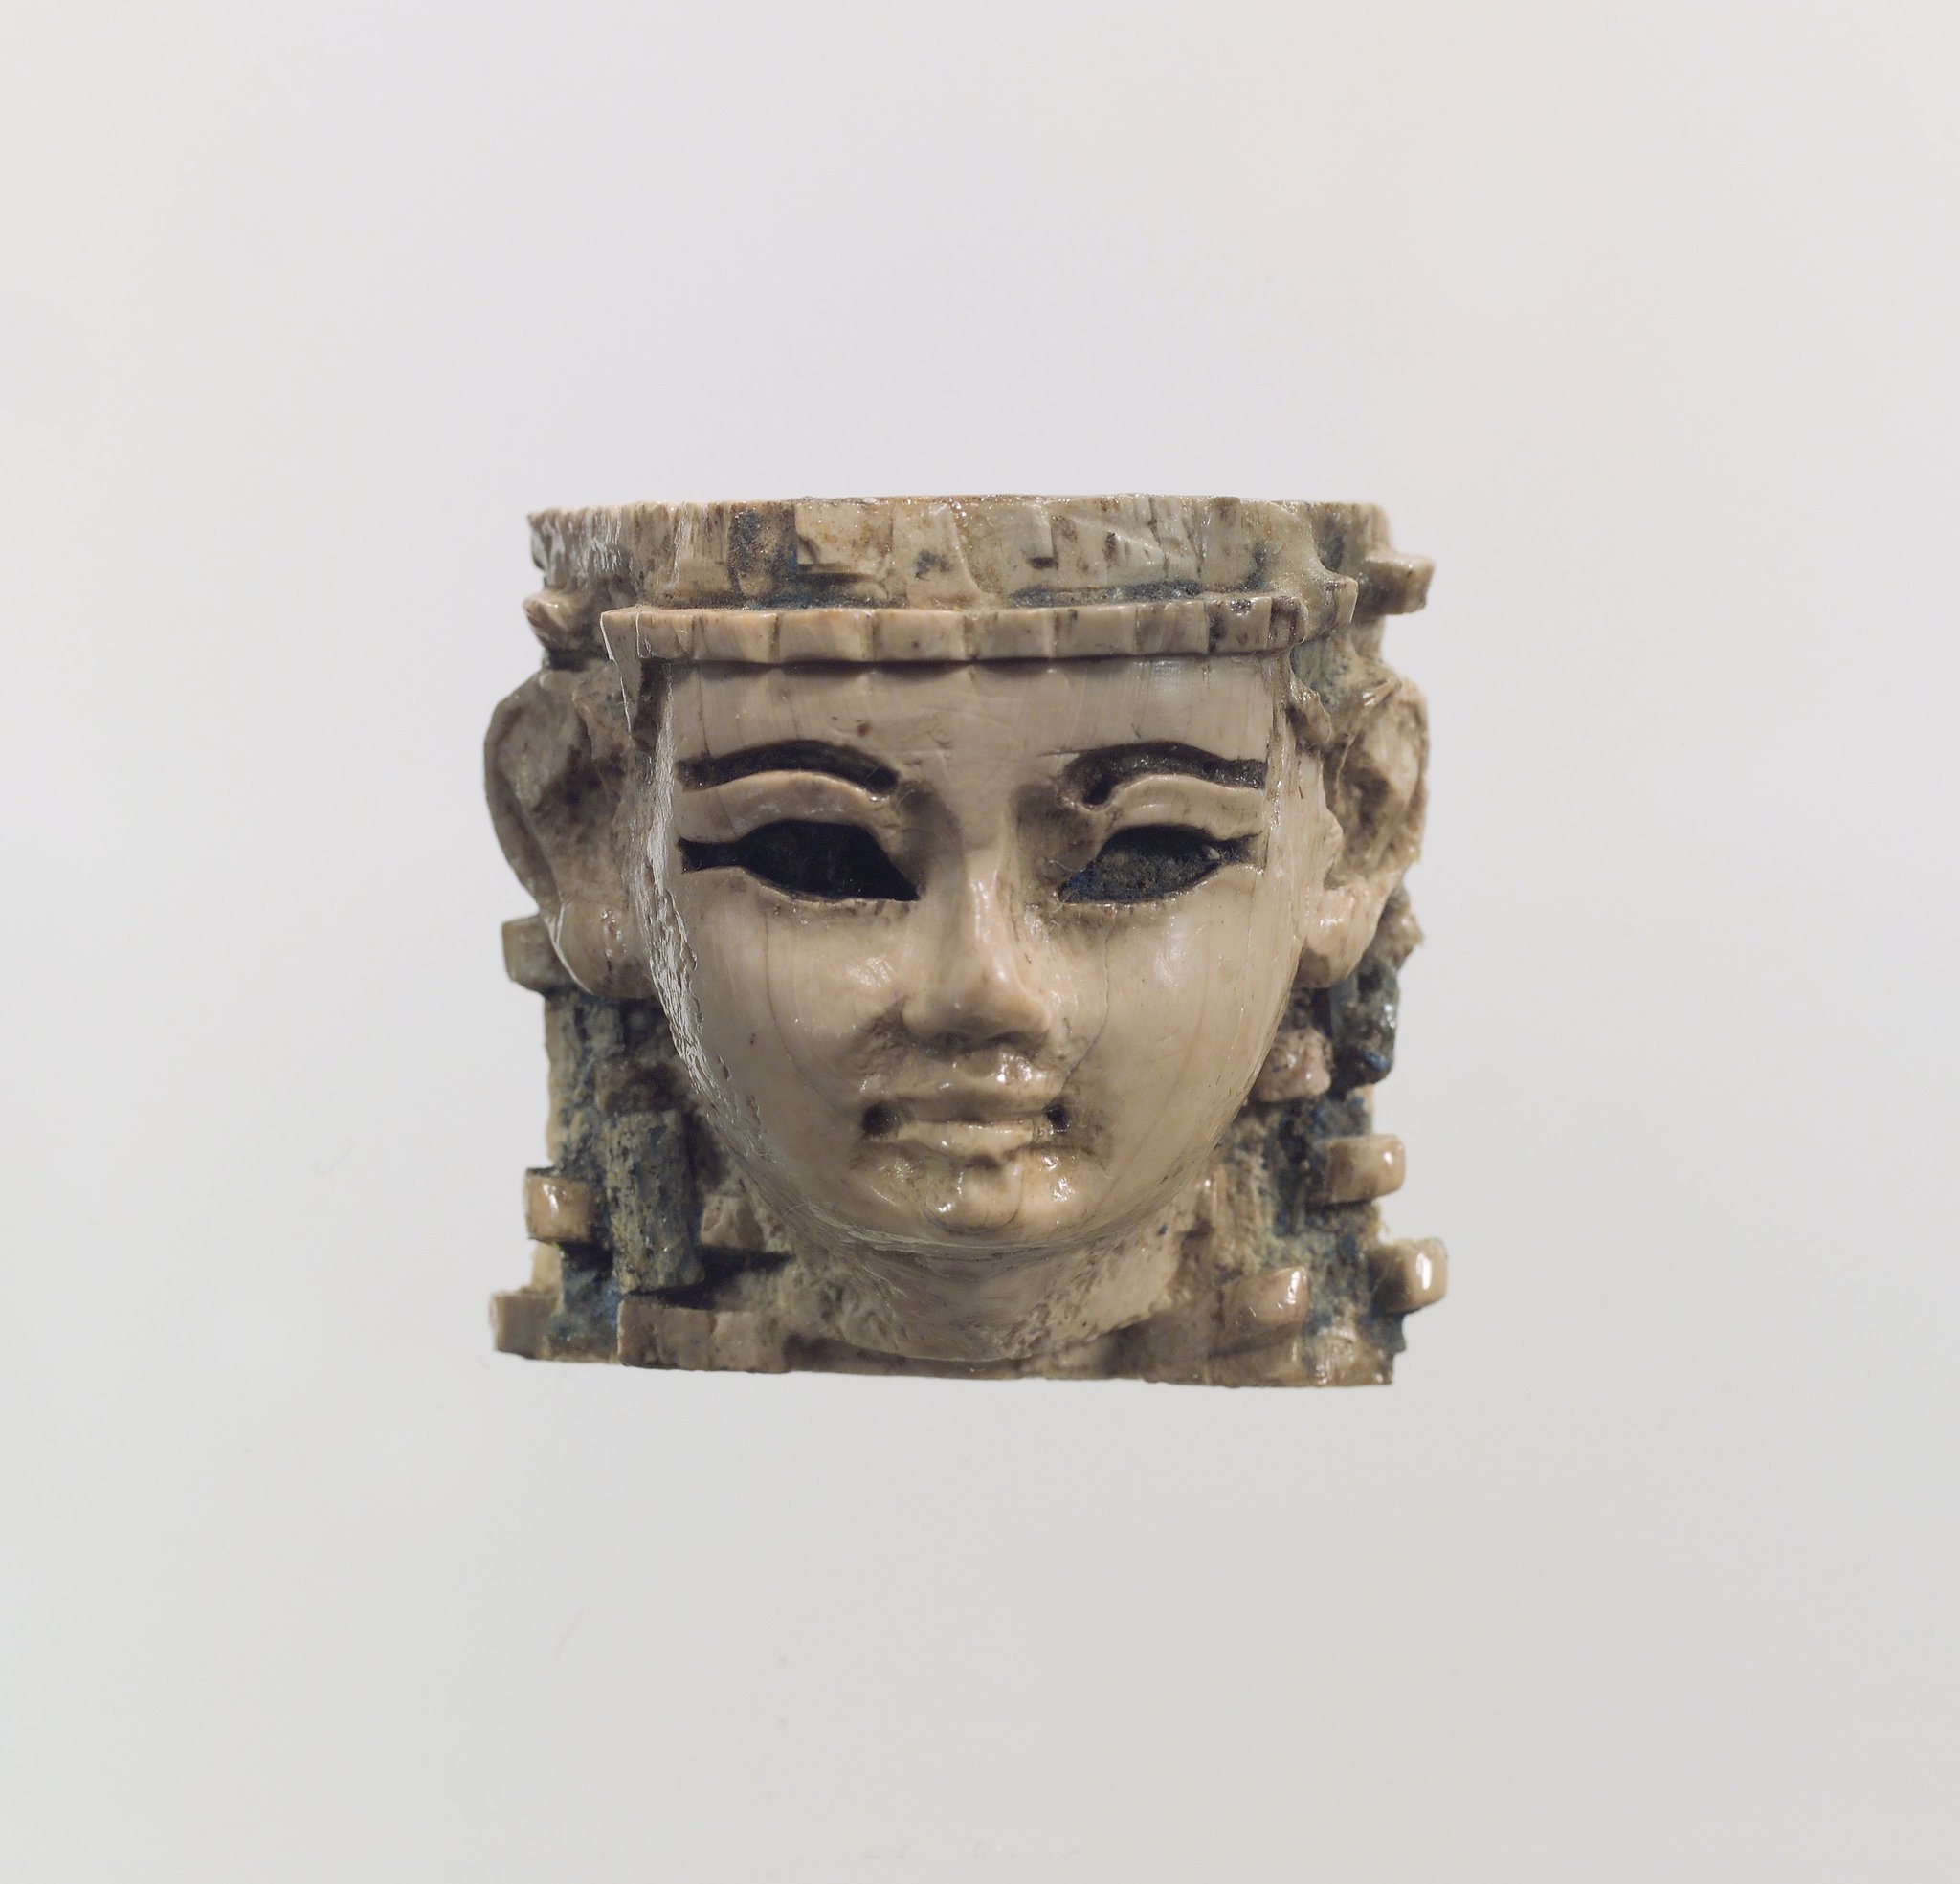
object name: sculpture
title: Head of a male or female figure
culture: assyrian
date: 900-701 BCE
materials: ivory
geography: mesopotamia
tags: heads